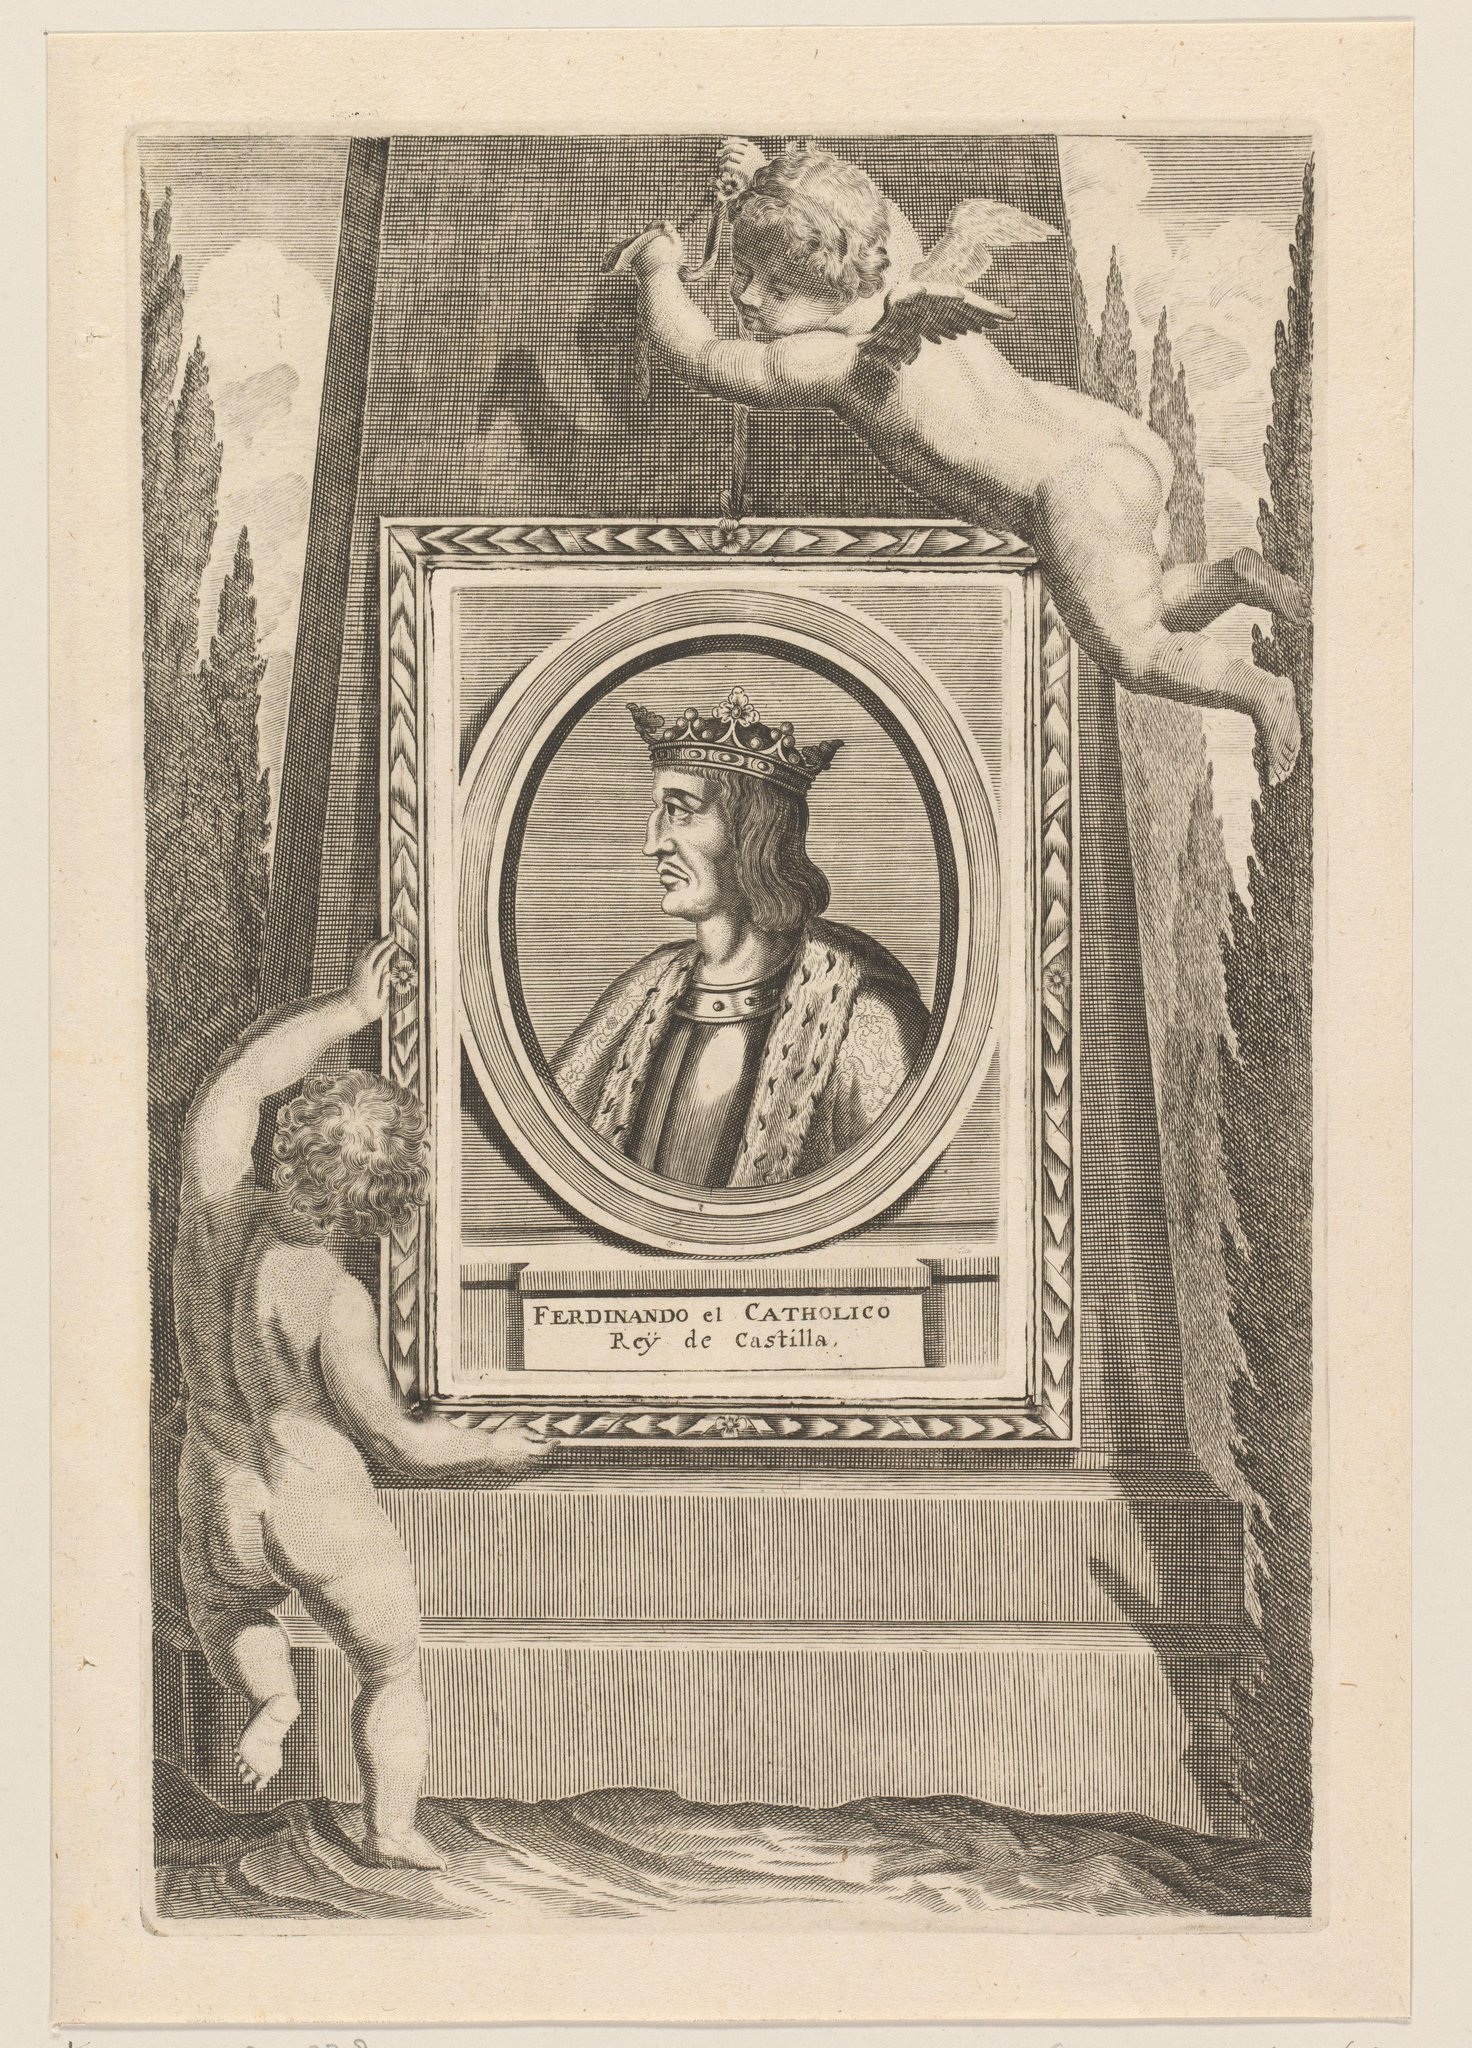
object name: print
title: Portret van Ferdinand I van León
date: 1713-1714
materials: paper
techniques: engraving, etching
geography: low countries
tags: historical persons, king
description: Prent waarschijnlijk uit: Komen, Filips van. Las Memorias (...). Antwerpen: Hendrik en Cornelis Verdussen, 1713, dl. 2. Of uit de editie uit 1714.